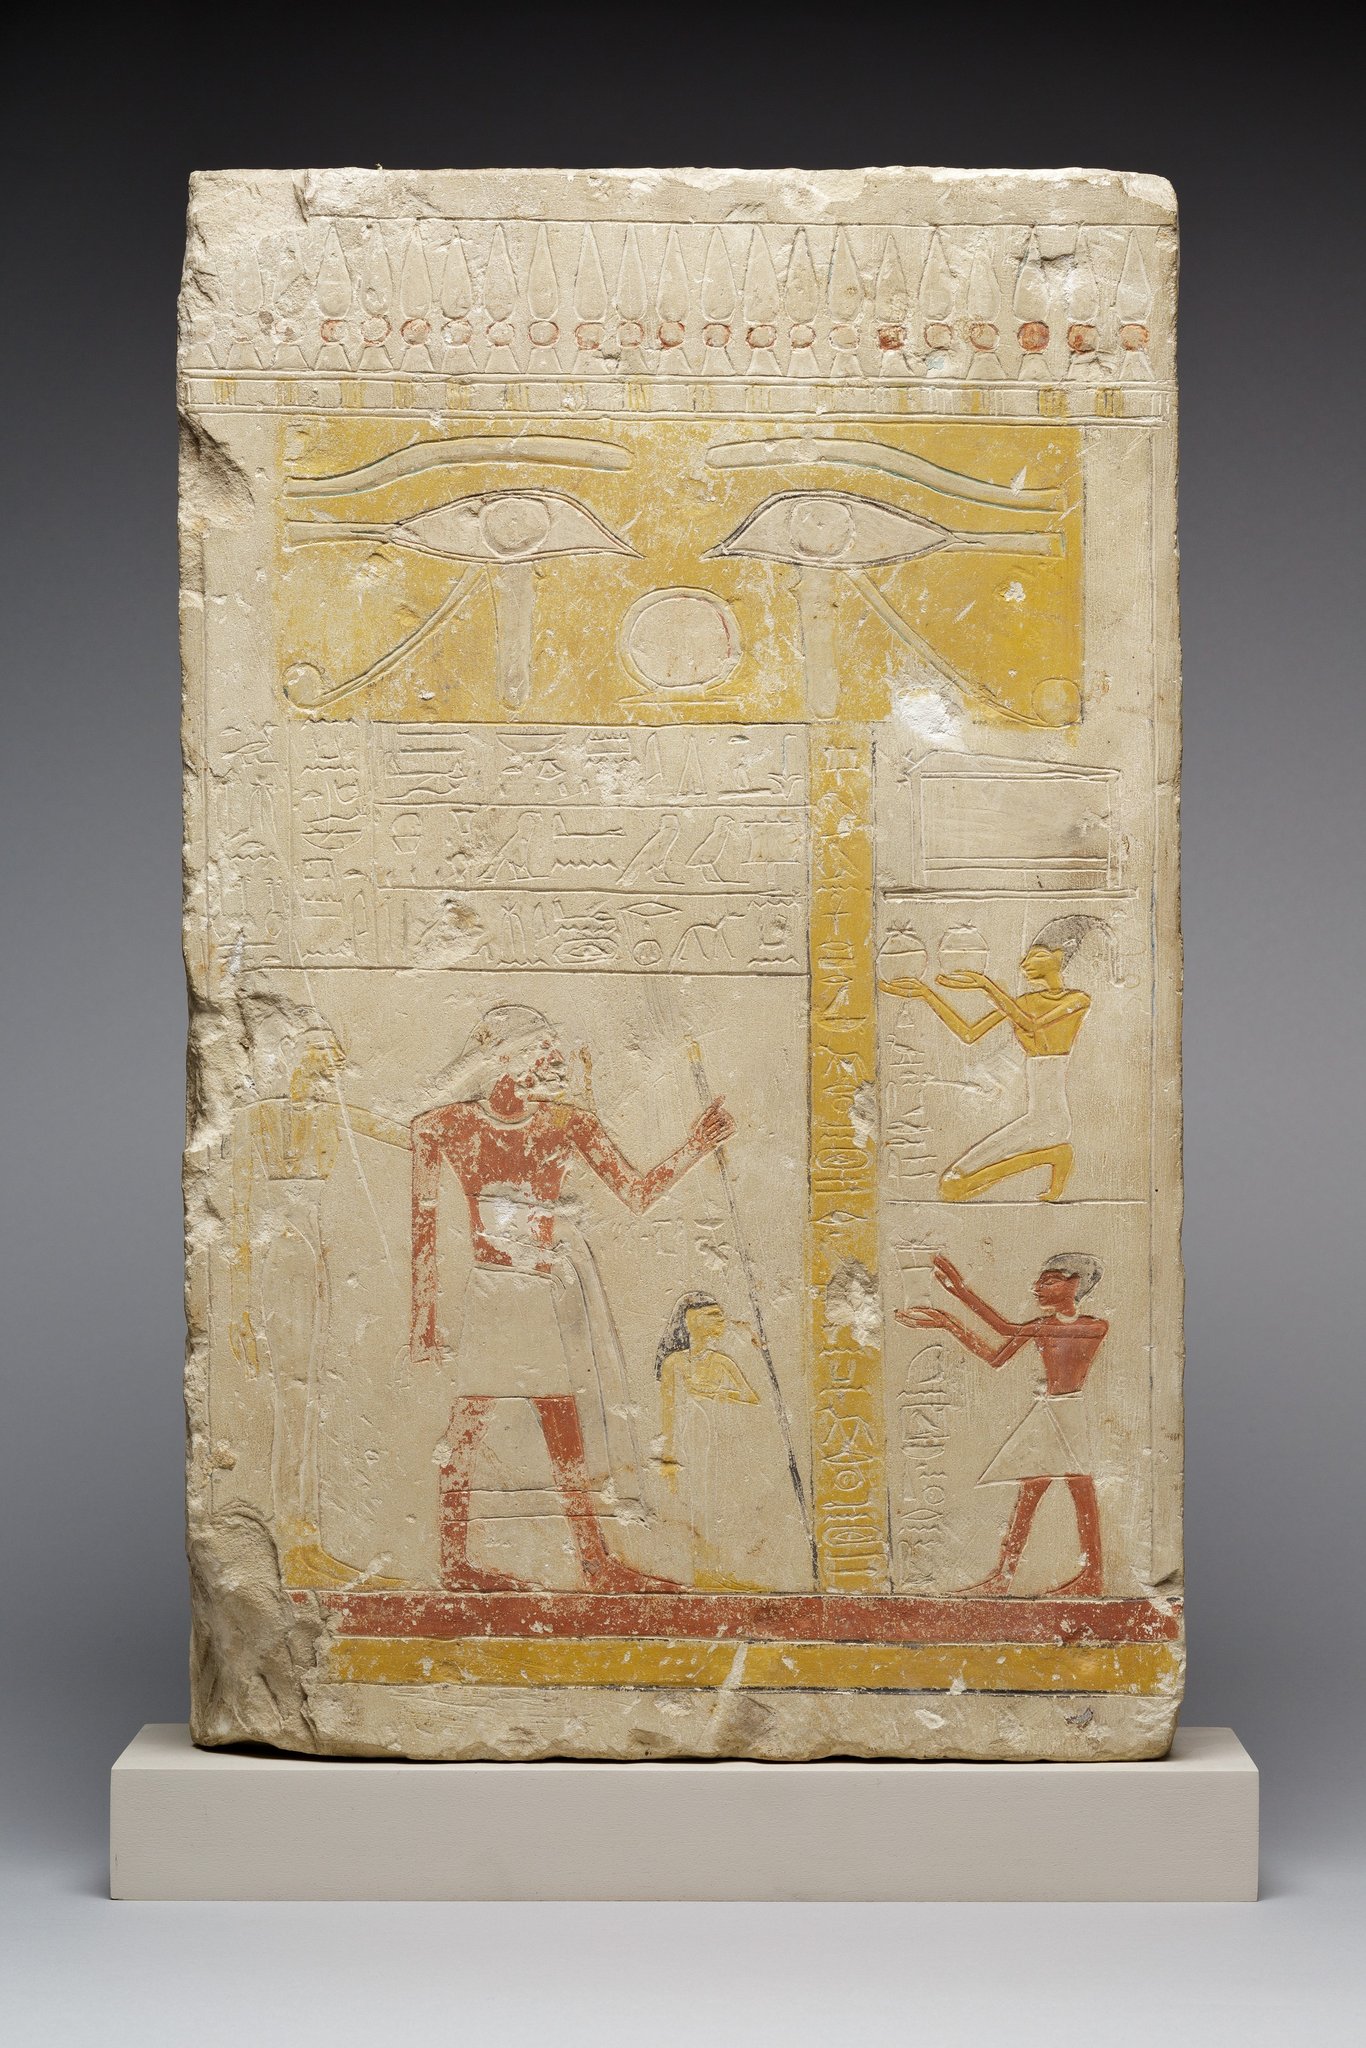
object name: stela, anu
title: Stela from a Chapel Niche of Anu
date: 1981-1640 BCE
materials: limestone, paint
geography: egypt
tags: men,women,hieroglyphs